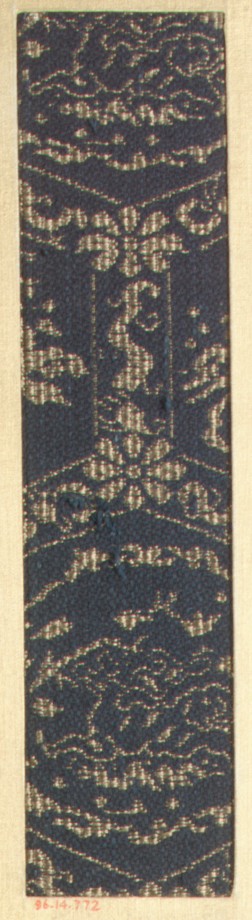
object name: piece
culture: japanese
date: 1701-1900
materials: silk